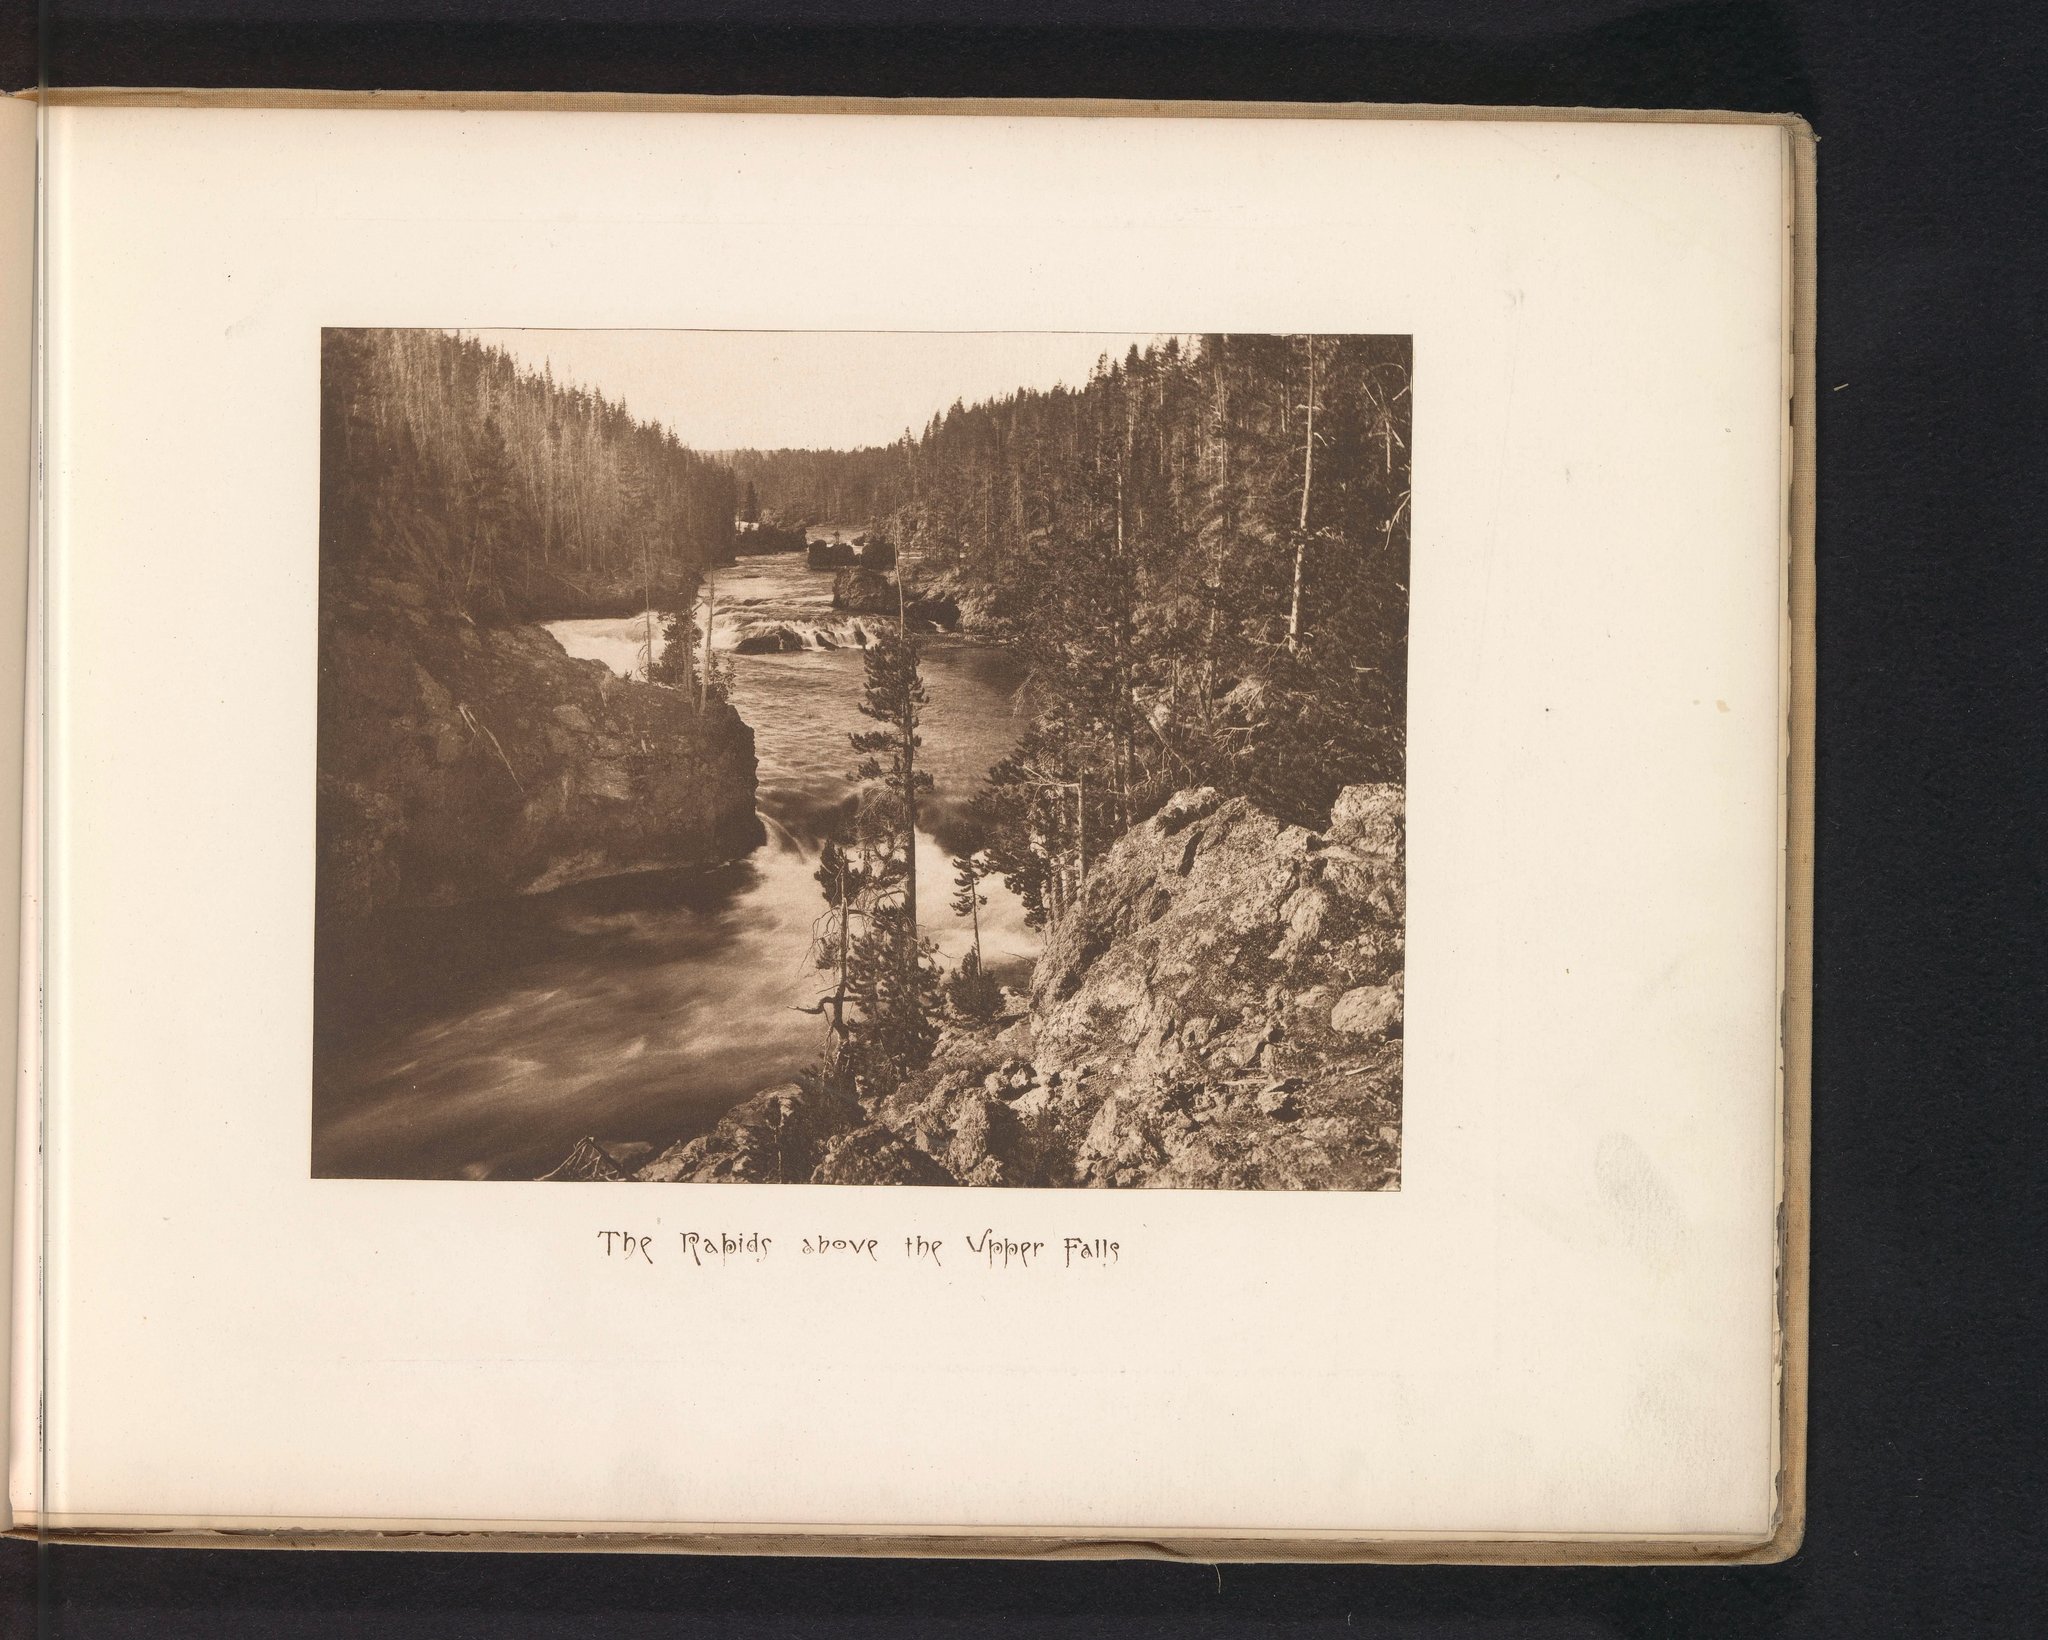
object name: photomechanical print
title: The rapids above the Upper Falls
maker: frank jay haynes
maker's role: fotograaf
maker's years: 1853-1921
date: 1882-1887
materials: paper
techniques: photoaquatint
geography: yellowstone national park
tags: rapids, river